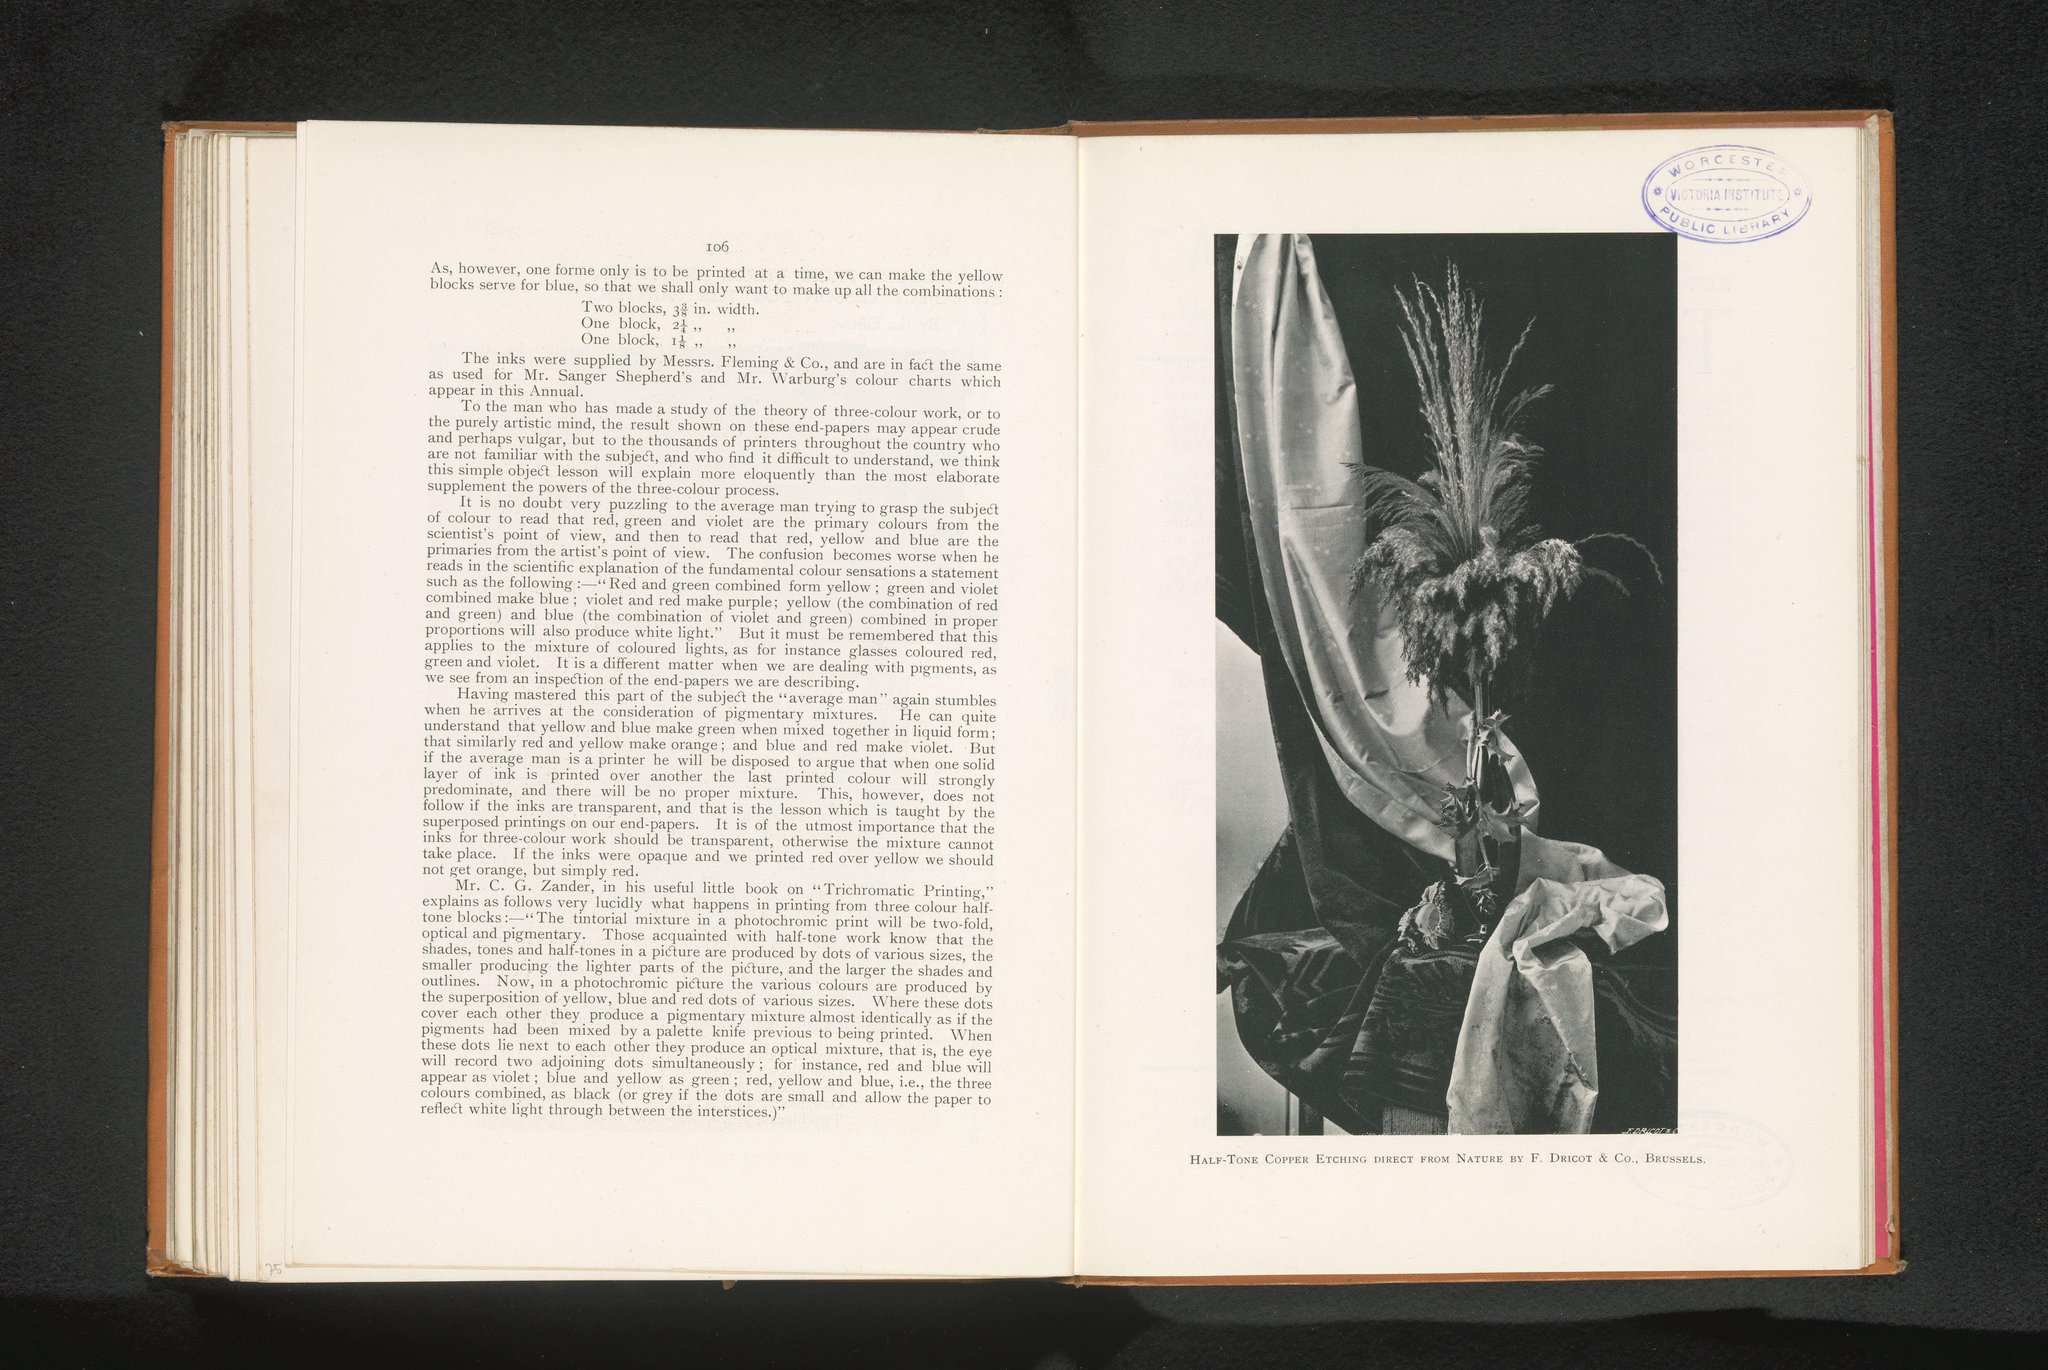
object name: photomechanical print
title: Bloemstilleven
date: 1894-1899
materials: paper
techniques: autotype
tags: flowers in a vase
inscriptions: collector's mark: ‘Worcester Public Library/ Victoria Institute’